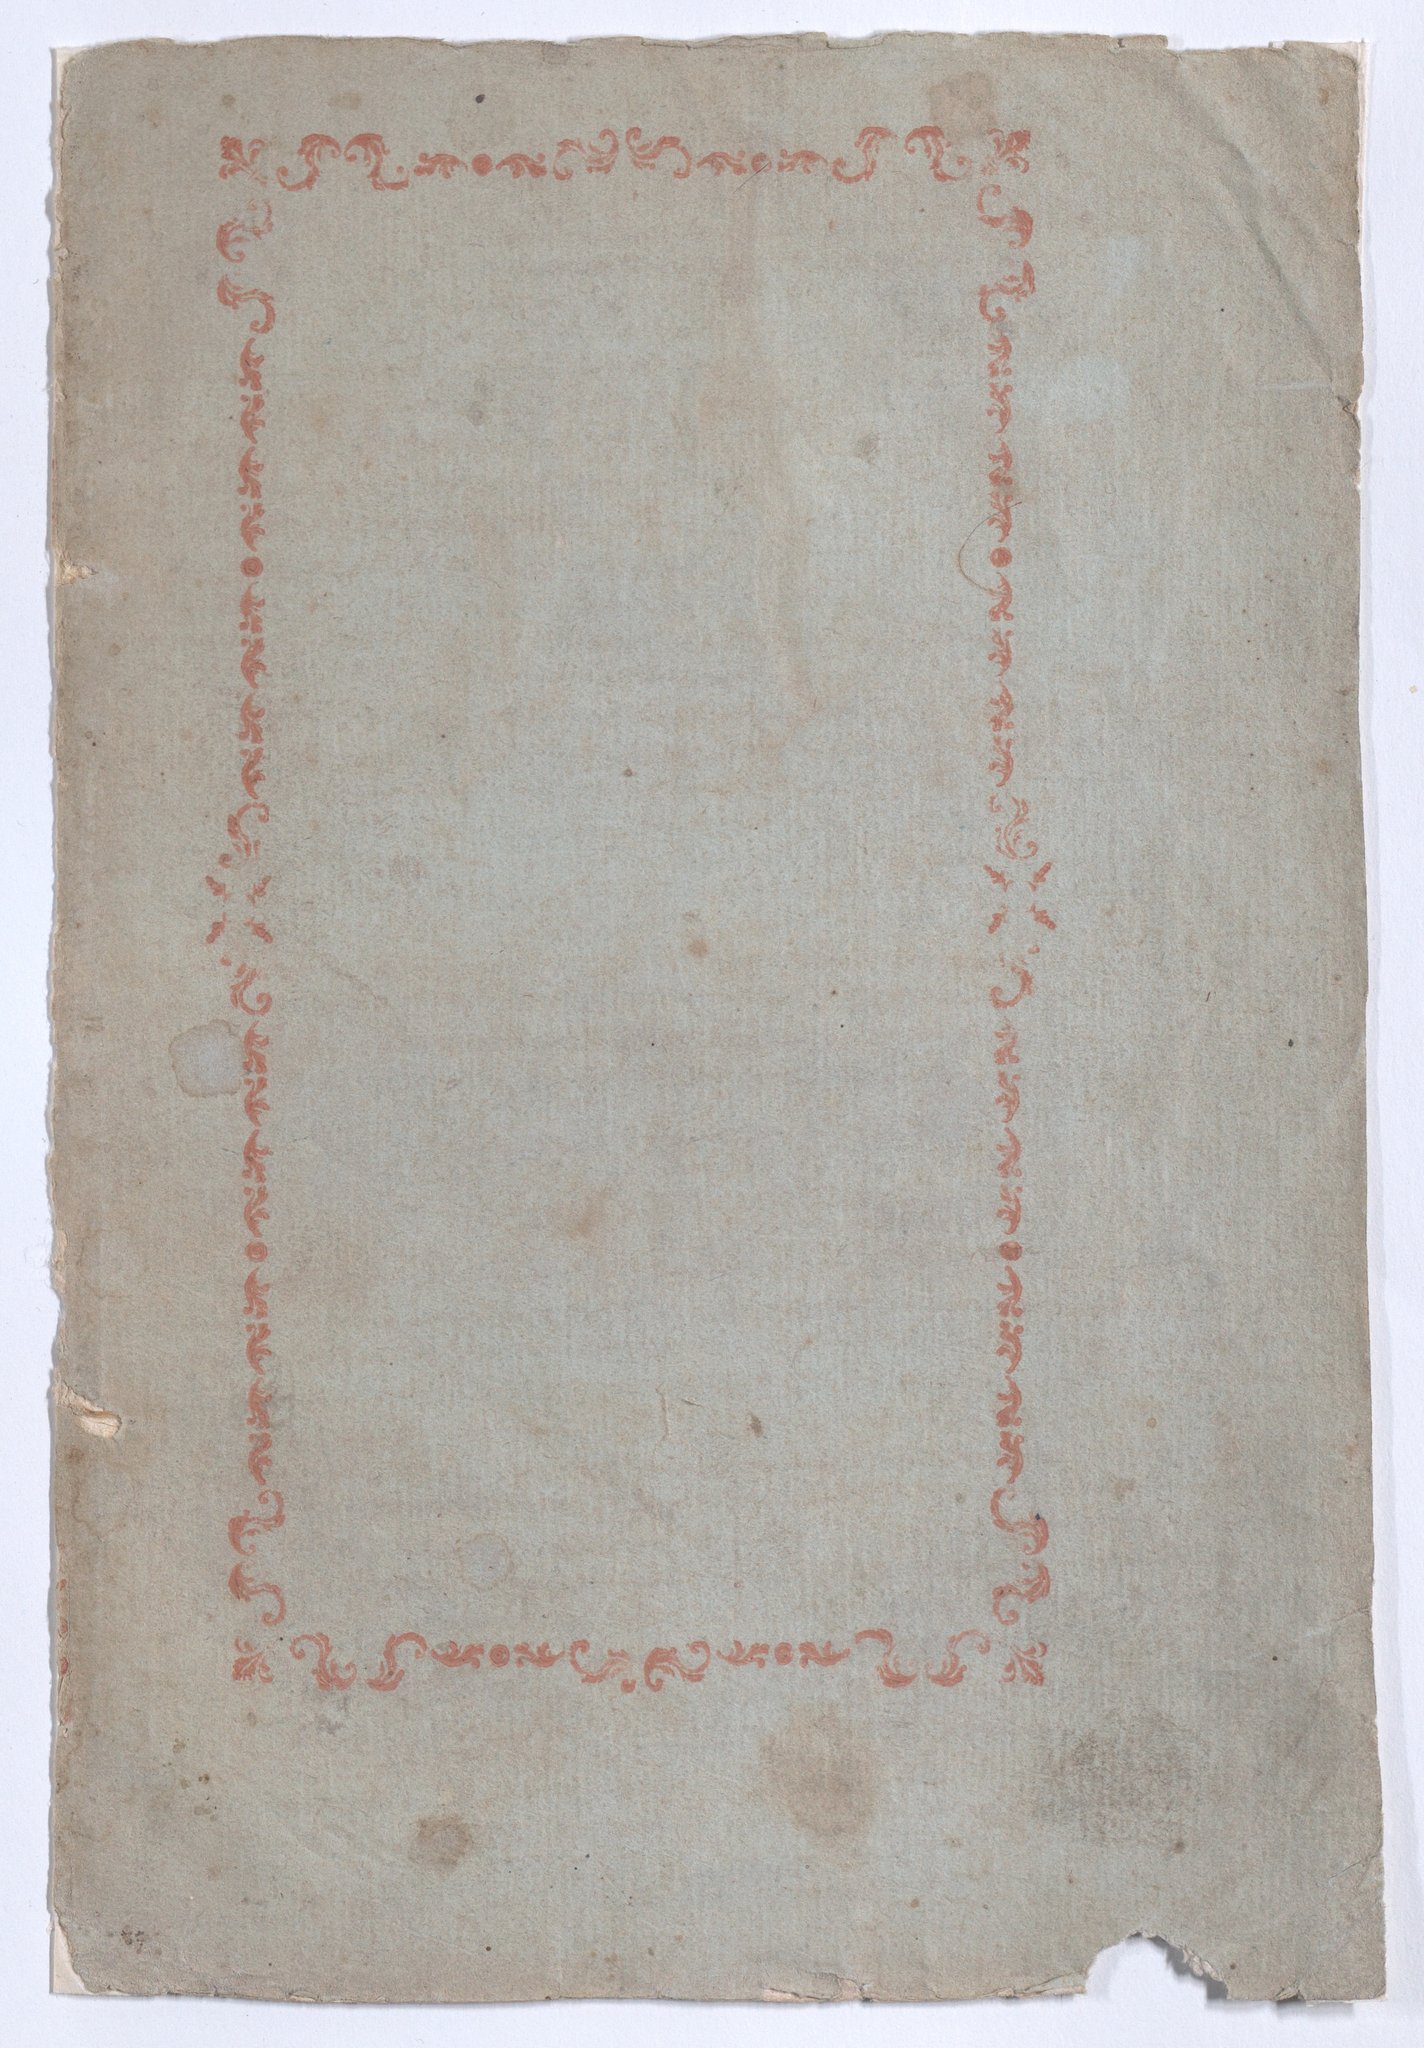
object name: print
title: Sheet with red rectangular design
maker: Anonymous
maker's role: artist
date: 1801-1900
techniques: letterpress